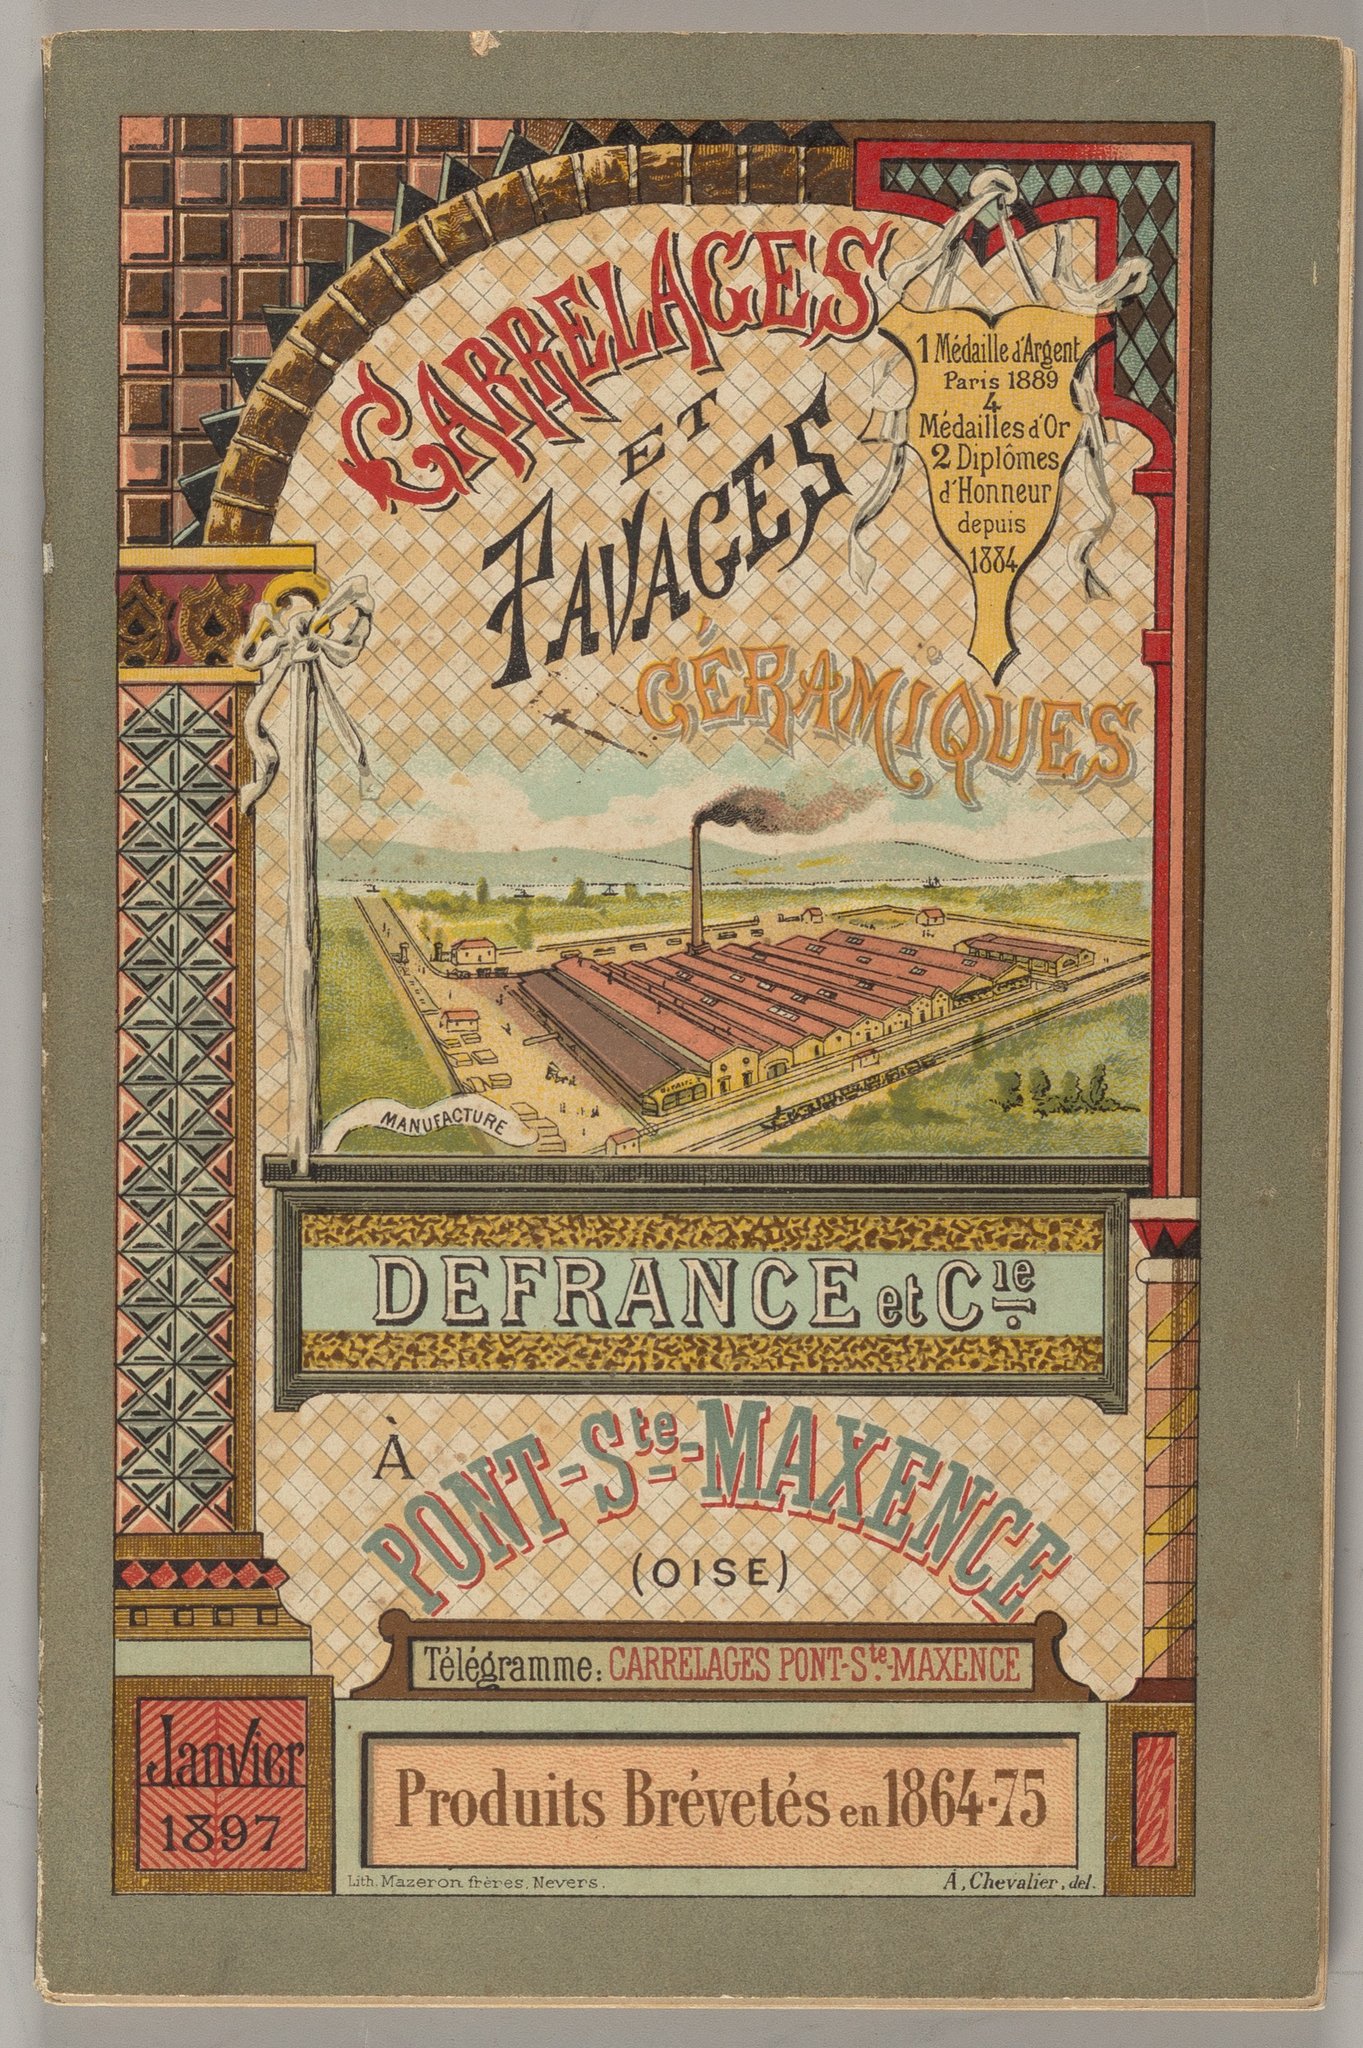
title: Carrelages & pavages céramiques : manufacture DeFrance et Comp.ie à Pont Ste. Maxence (Oise)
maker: defrance et cie.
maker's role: author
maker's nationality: french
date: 1897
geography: france